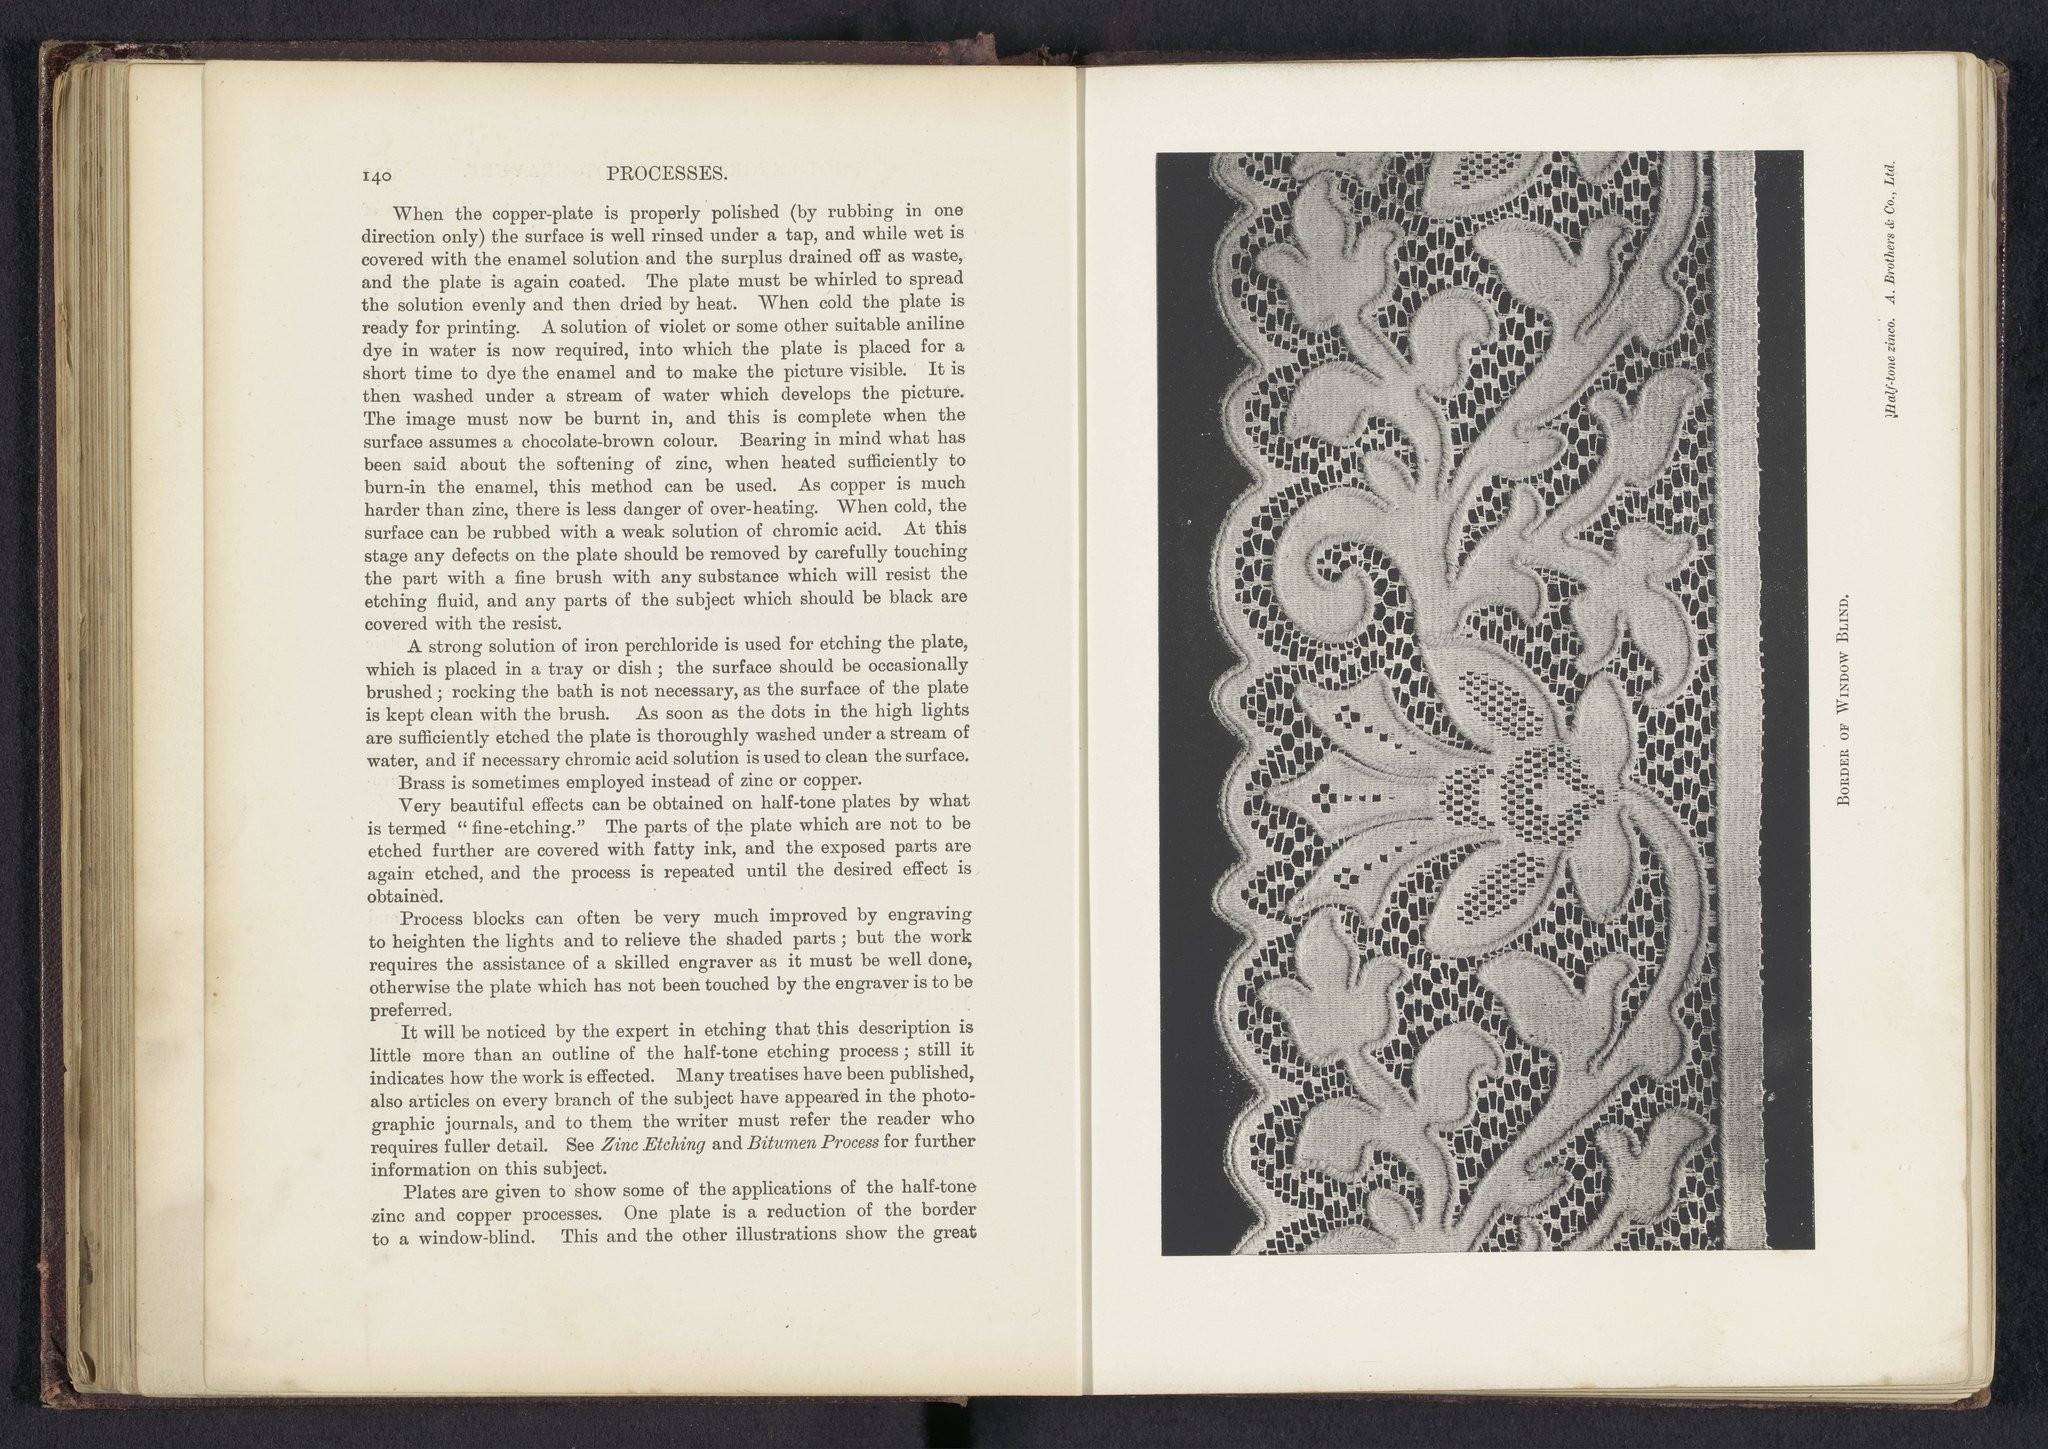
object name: photomechanical print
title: Border of window blind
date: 1889-1899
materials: paper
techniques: photo-zincography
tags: curtains, lace